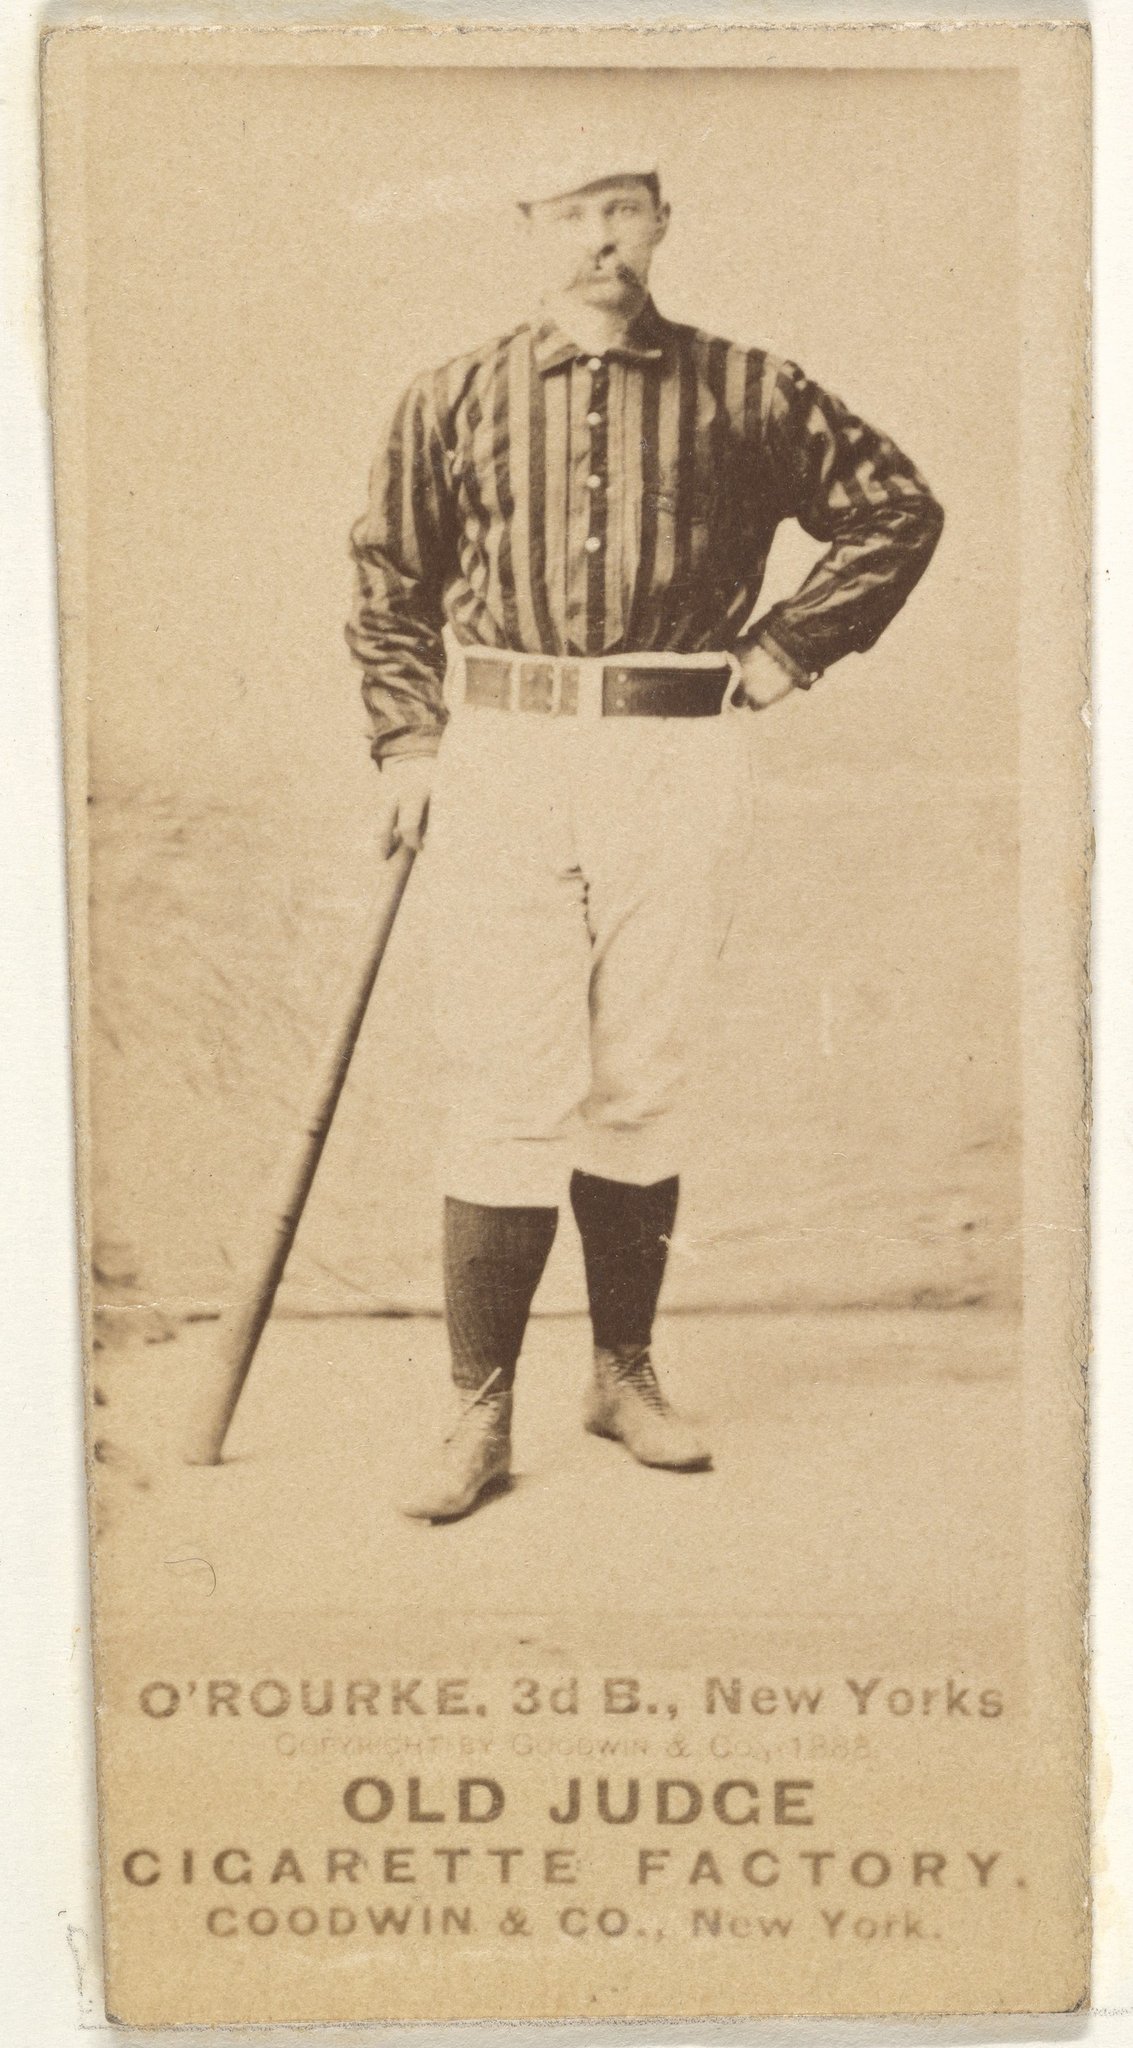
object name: baseball card, photograph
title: James Henry O'Rourke, 3rd Base, New York, from the Old Judge series (N172) for Old Judge Cigarettes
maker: goodwin & company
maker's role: publisher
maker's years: 1850-1950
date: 1888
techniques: albumen silver print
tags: men,portraits,baseball,athletes